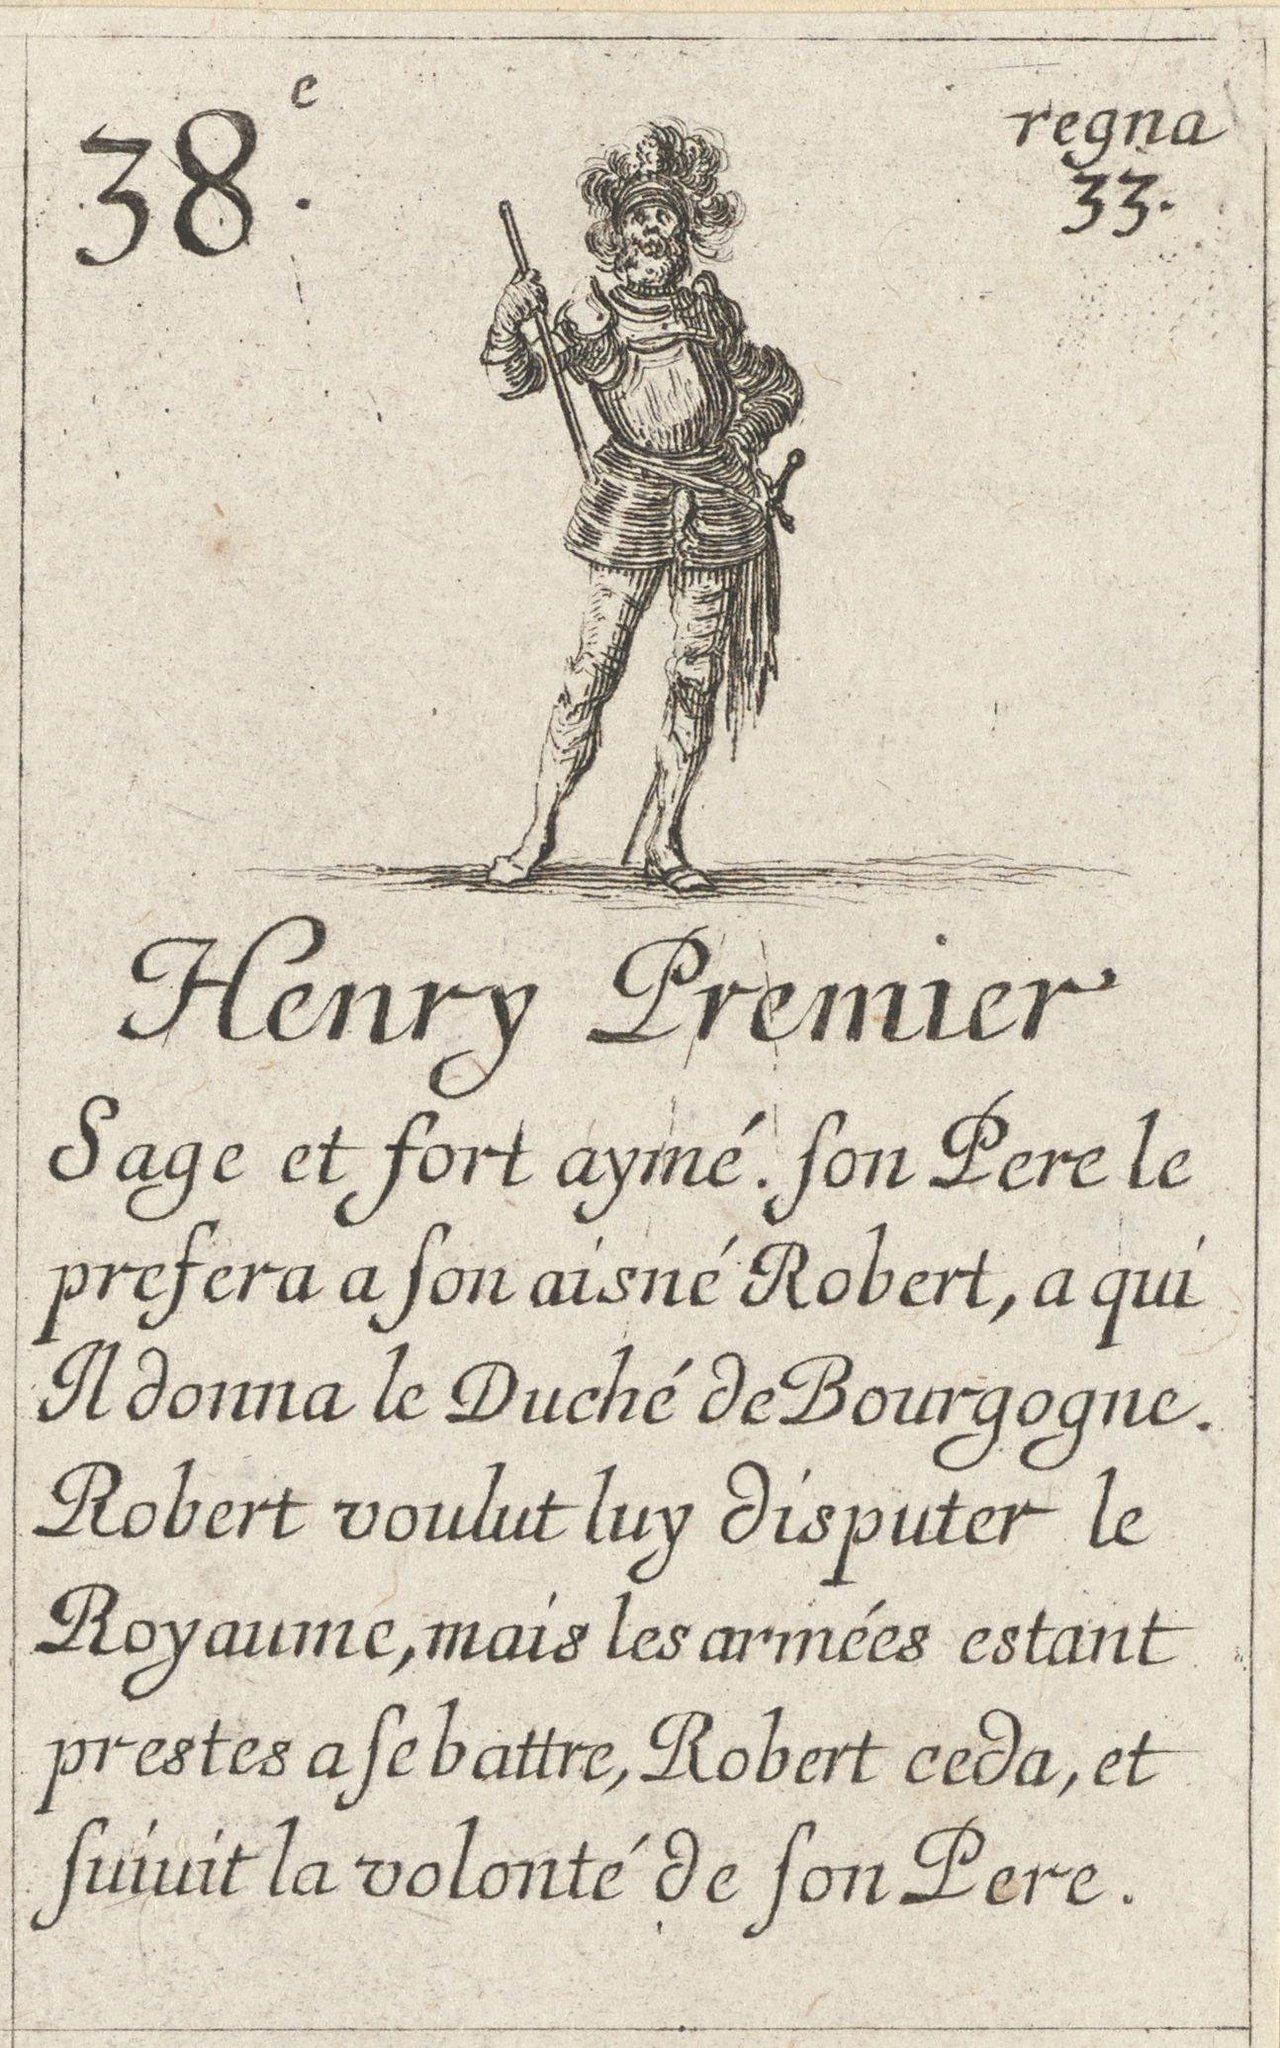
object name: print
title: Cartes des rois de France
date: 1620-1664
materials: paper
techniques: etching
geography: paris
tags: ruler, sovereign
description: Deze prent maakt deel uit van een kaartspel met 39 kaarten met voorstellingen van Franse koningen. De serie is uitgedacht door Jean Desmarests de Saint-Sorlin in opdracht van Kardinaal Mazarin. Het kaartspel werd gemaakt voor de jonge Lodewijk XIV, samen met het Jeu des Fables, Jeu des Reynes Renommées en Jeu de la géographie.